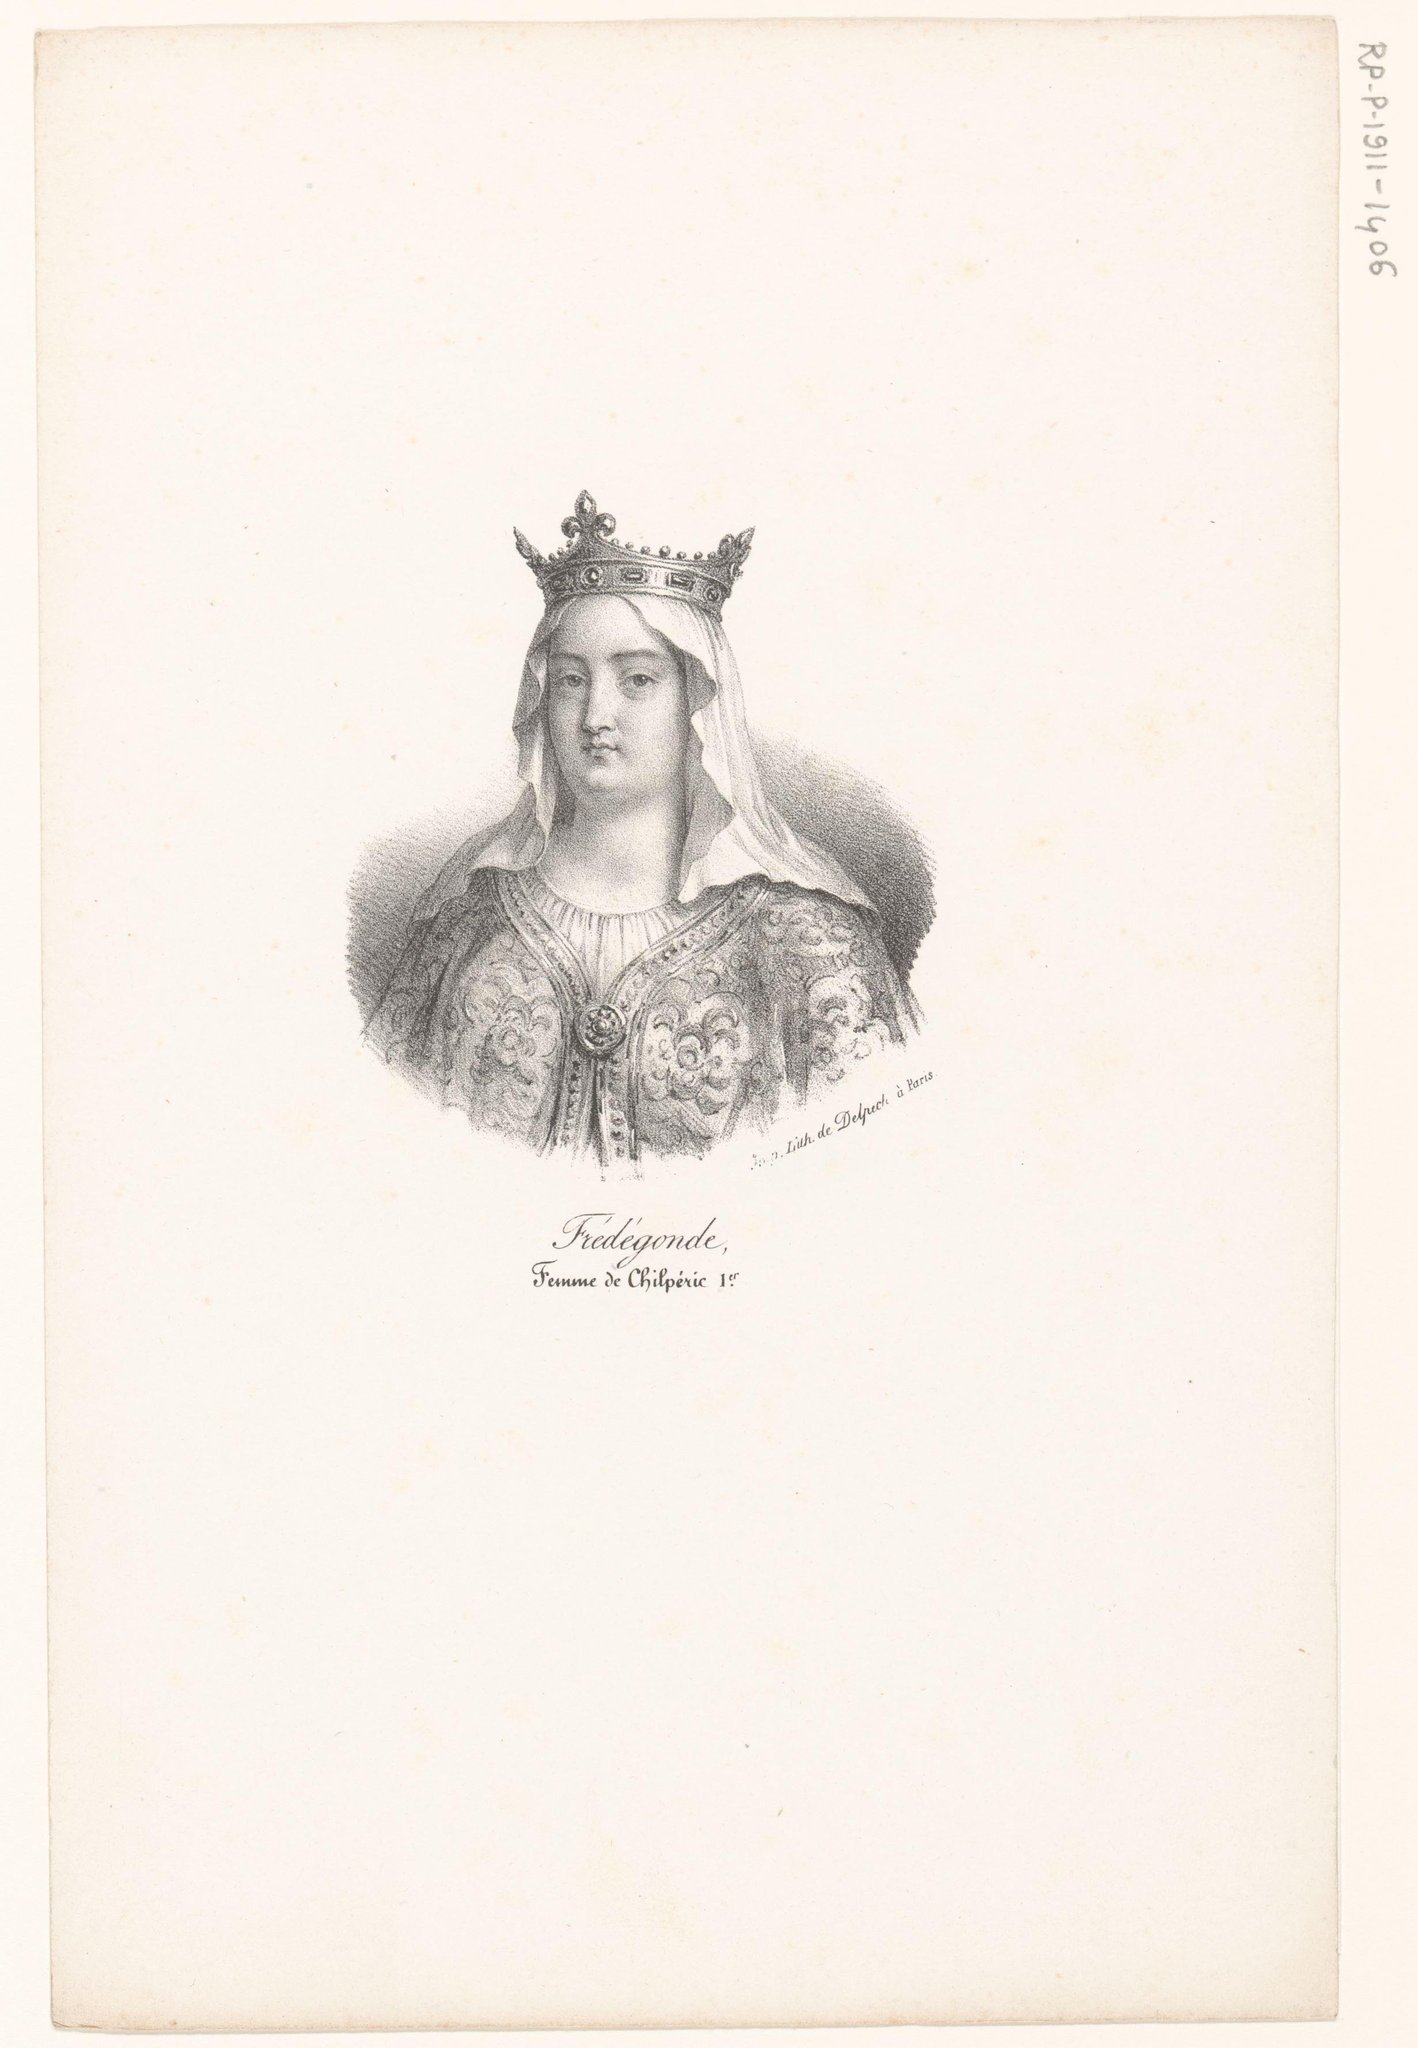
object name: print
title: Portret van koningin Fredegonde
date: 1818-1842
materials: paper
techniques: lithograph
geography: paris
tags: paris, historical persons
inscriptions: collector's mark: Lugt 2228a